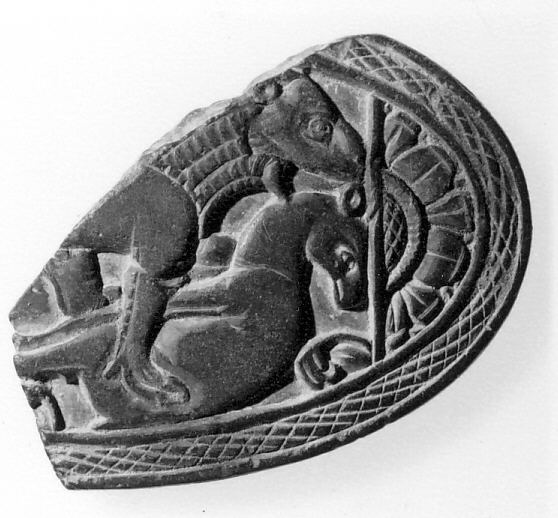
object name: box lid fragment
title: Fragment of a Box Lid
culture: gandhara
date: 401-500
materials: stone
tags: animals,gandhara